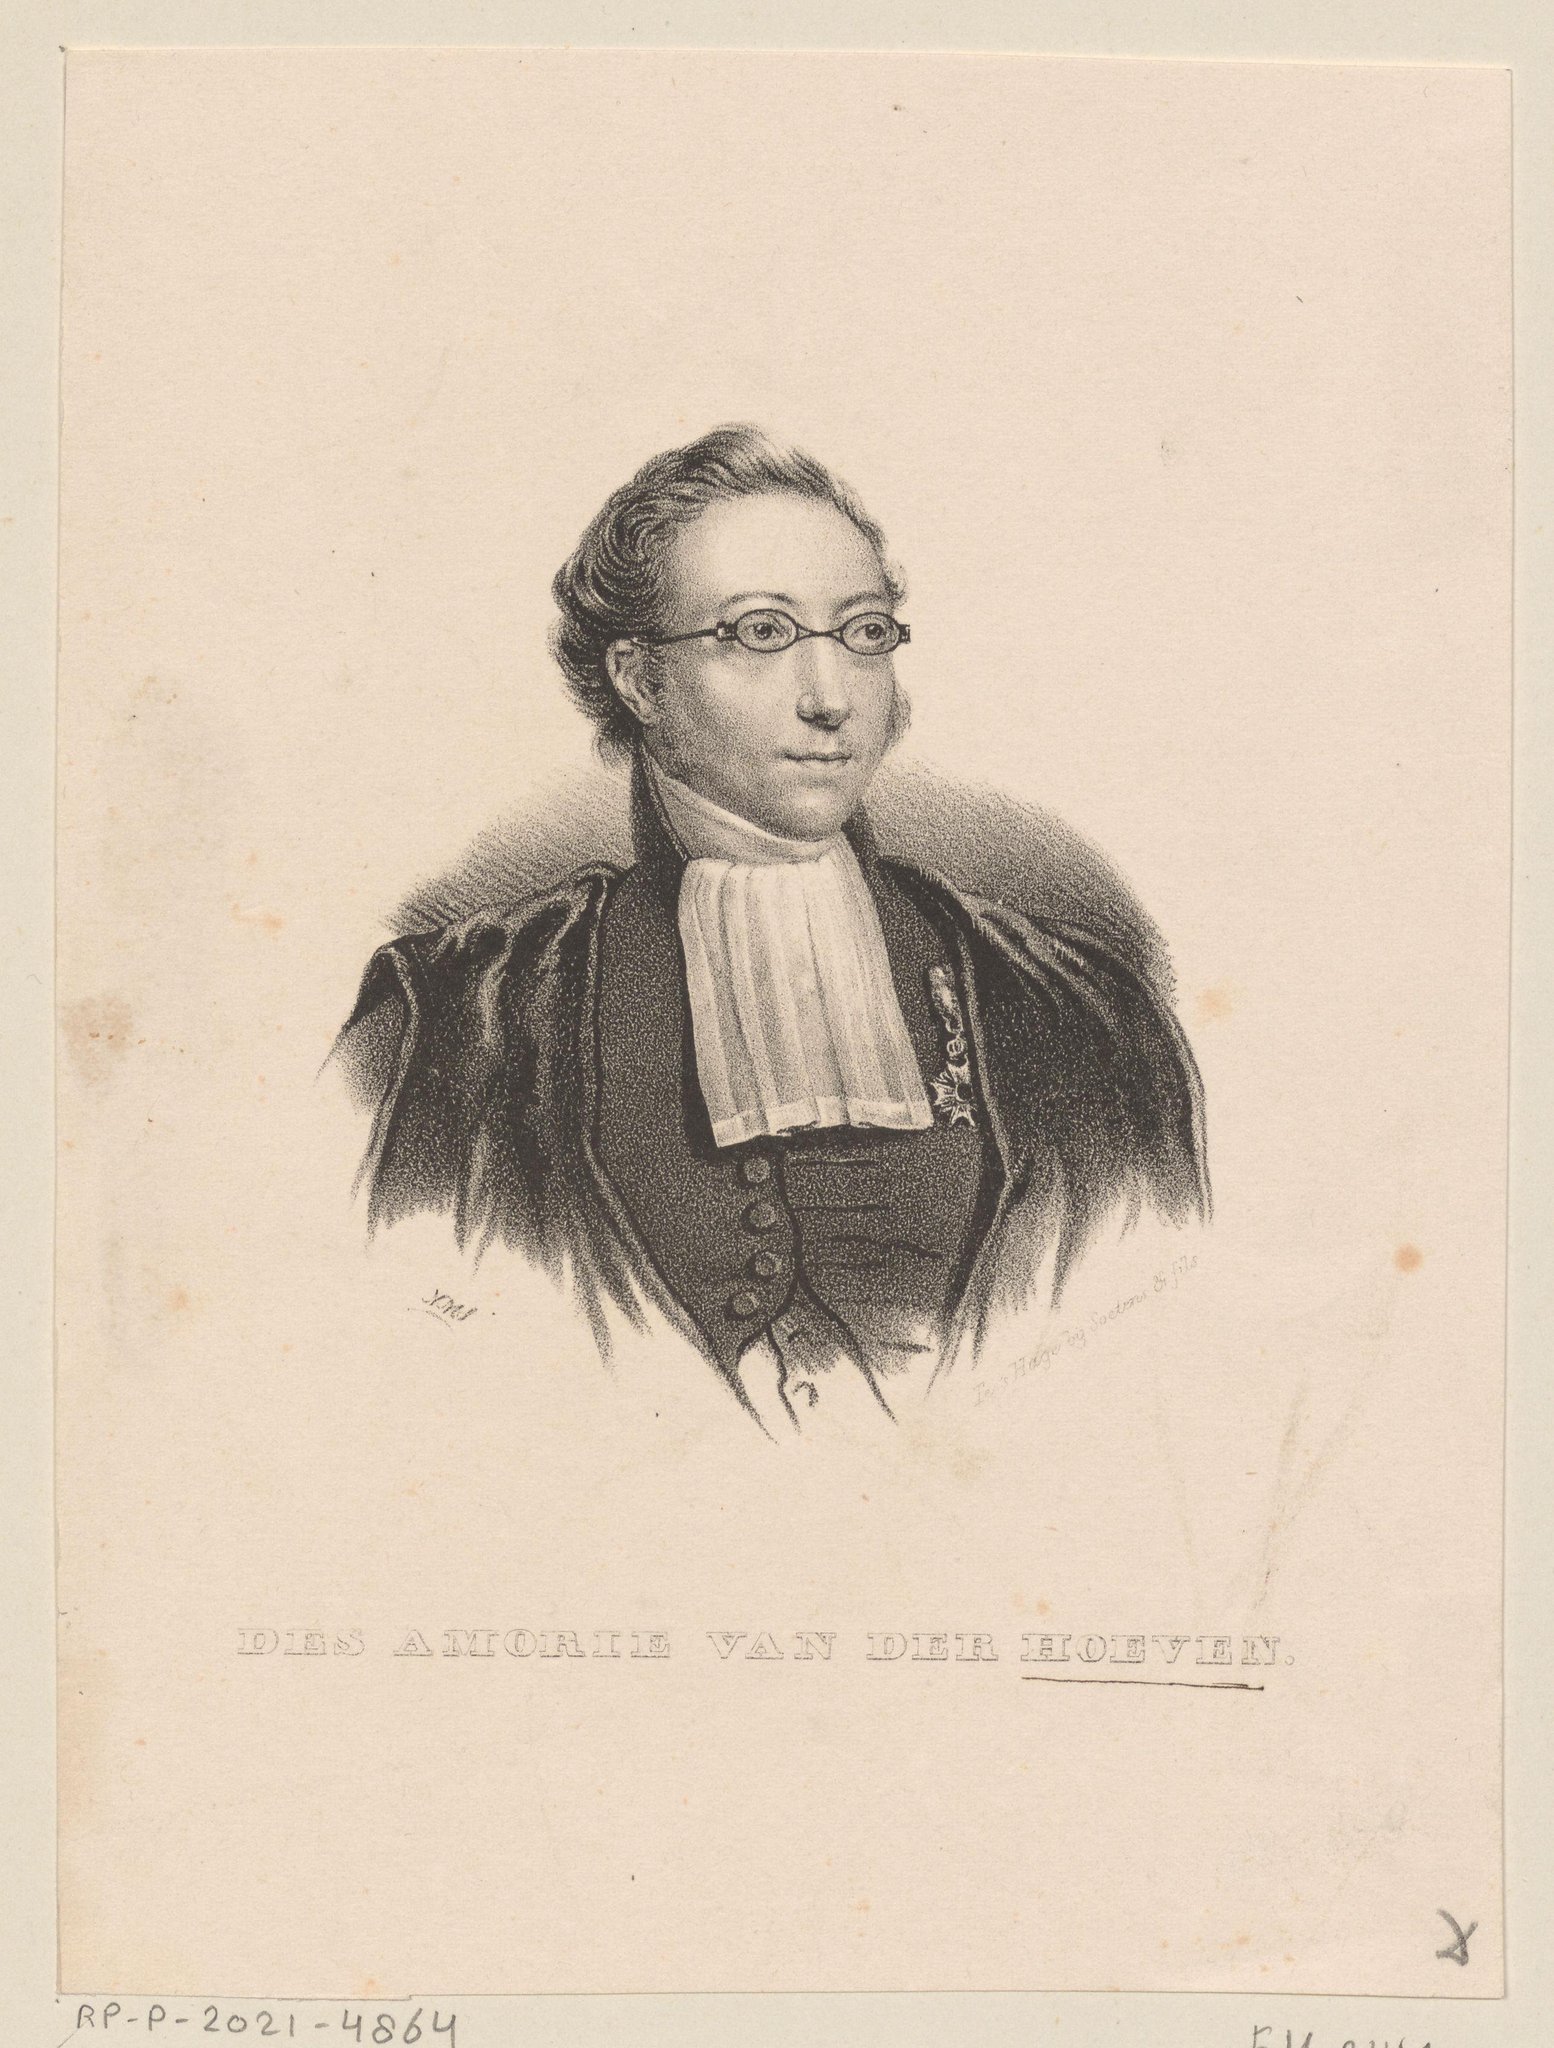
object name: print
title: Portret van Abraham des Amorie van der Hoeven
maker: nicolaas martinus schild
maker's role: draughtsman, print maker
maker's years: 1822-1840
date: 1837-1840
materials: paper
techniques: lithograph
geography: the hague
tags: rotterdam, arnhem, eyeglasses, spectacles, knighthood order, historical persons, professor